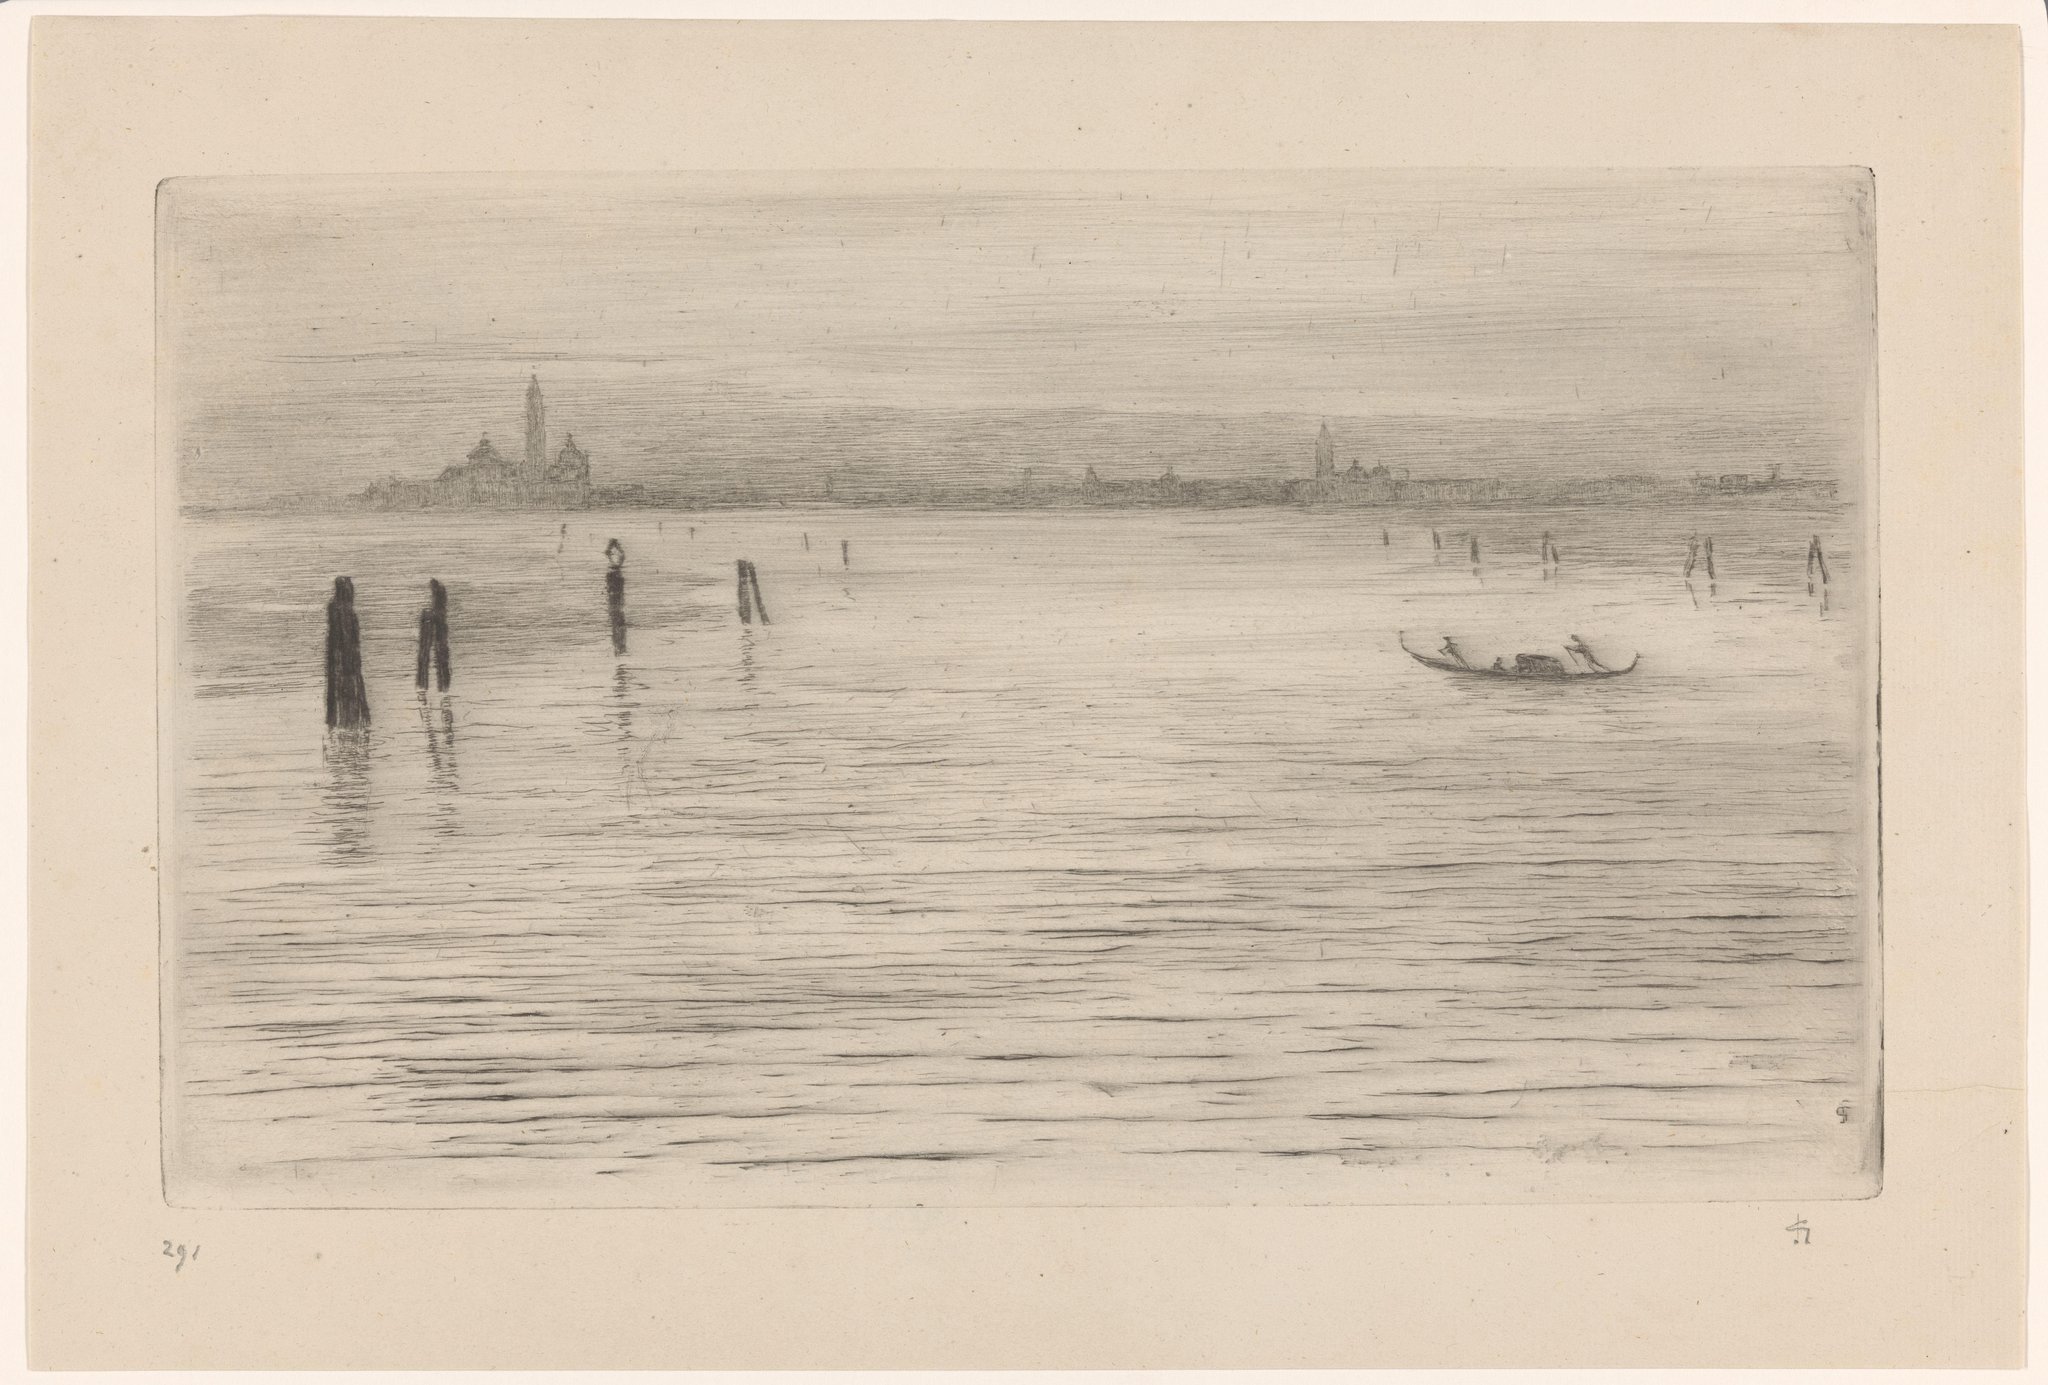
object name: print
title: Gezicht op Venetië vanaf Lido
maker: carel nicolaas storm van s-gravesande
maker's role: draughtsman, print maker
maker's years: 1841-1924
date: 1889-1903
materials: paper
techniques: drypoint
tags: haff, lagoon created by sand, shingle bank ~ coast, gondola, prospect of city, town panorama, silhouette of city, venice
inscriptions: collector's mark: Lugt 2228, number: ‘291’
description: Mogelijk vermeld in: Storm van 's-Gravesande, Charles. Catalogue des eaux-fortes et lithographies. New York: s.n., 1903, of in een onbekende latere uitgave van het manuscript. Vermoedelijk vermeld als catalogusnummer 291.